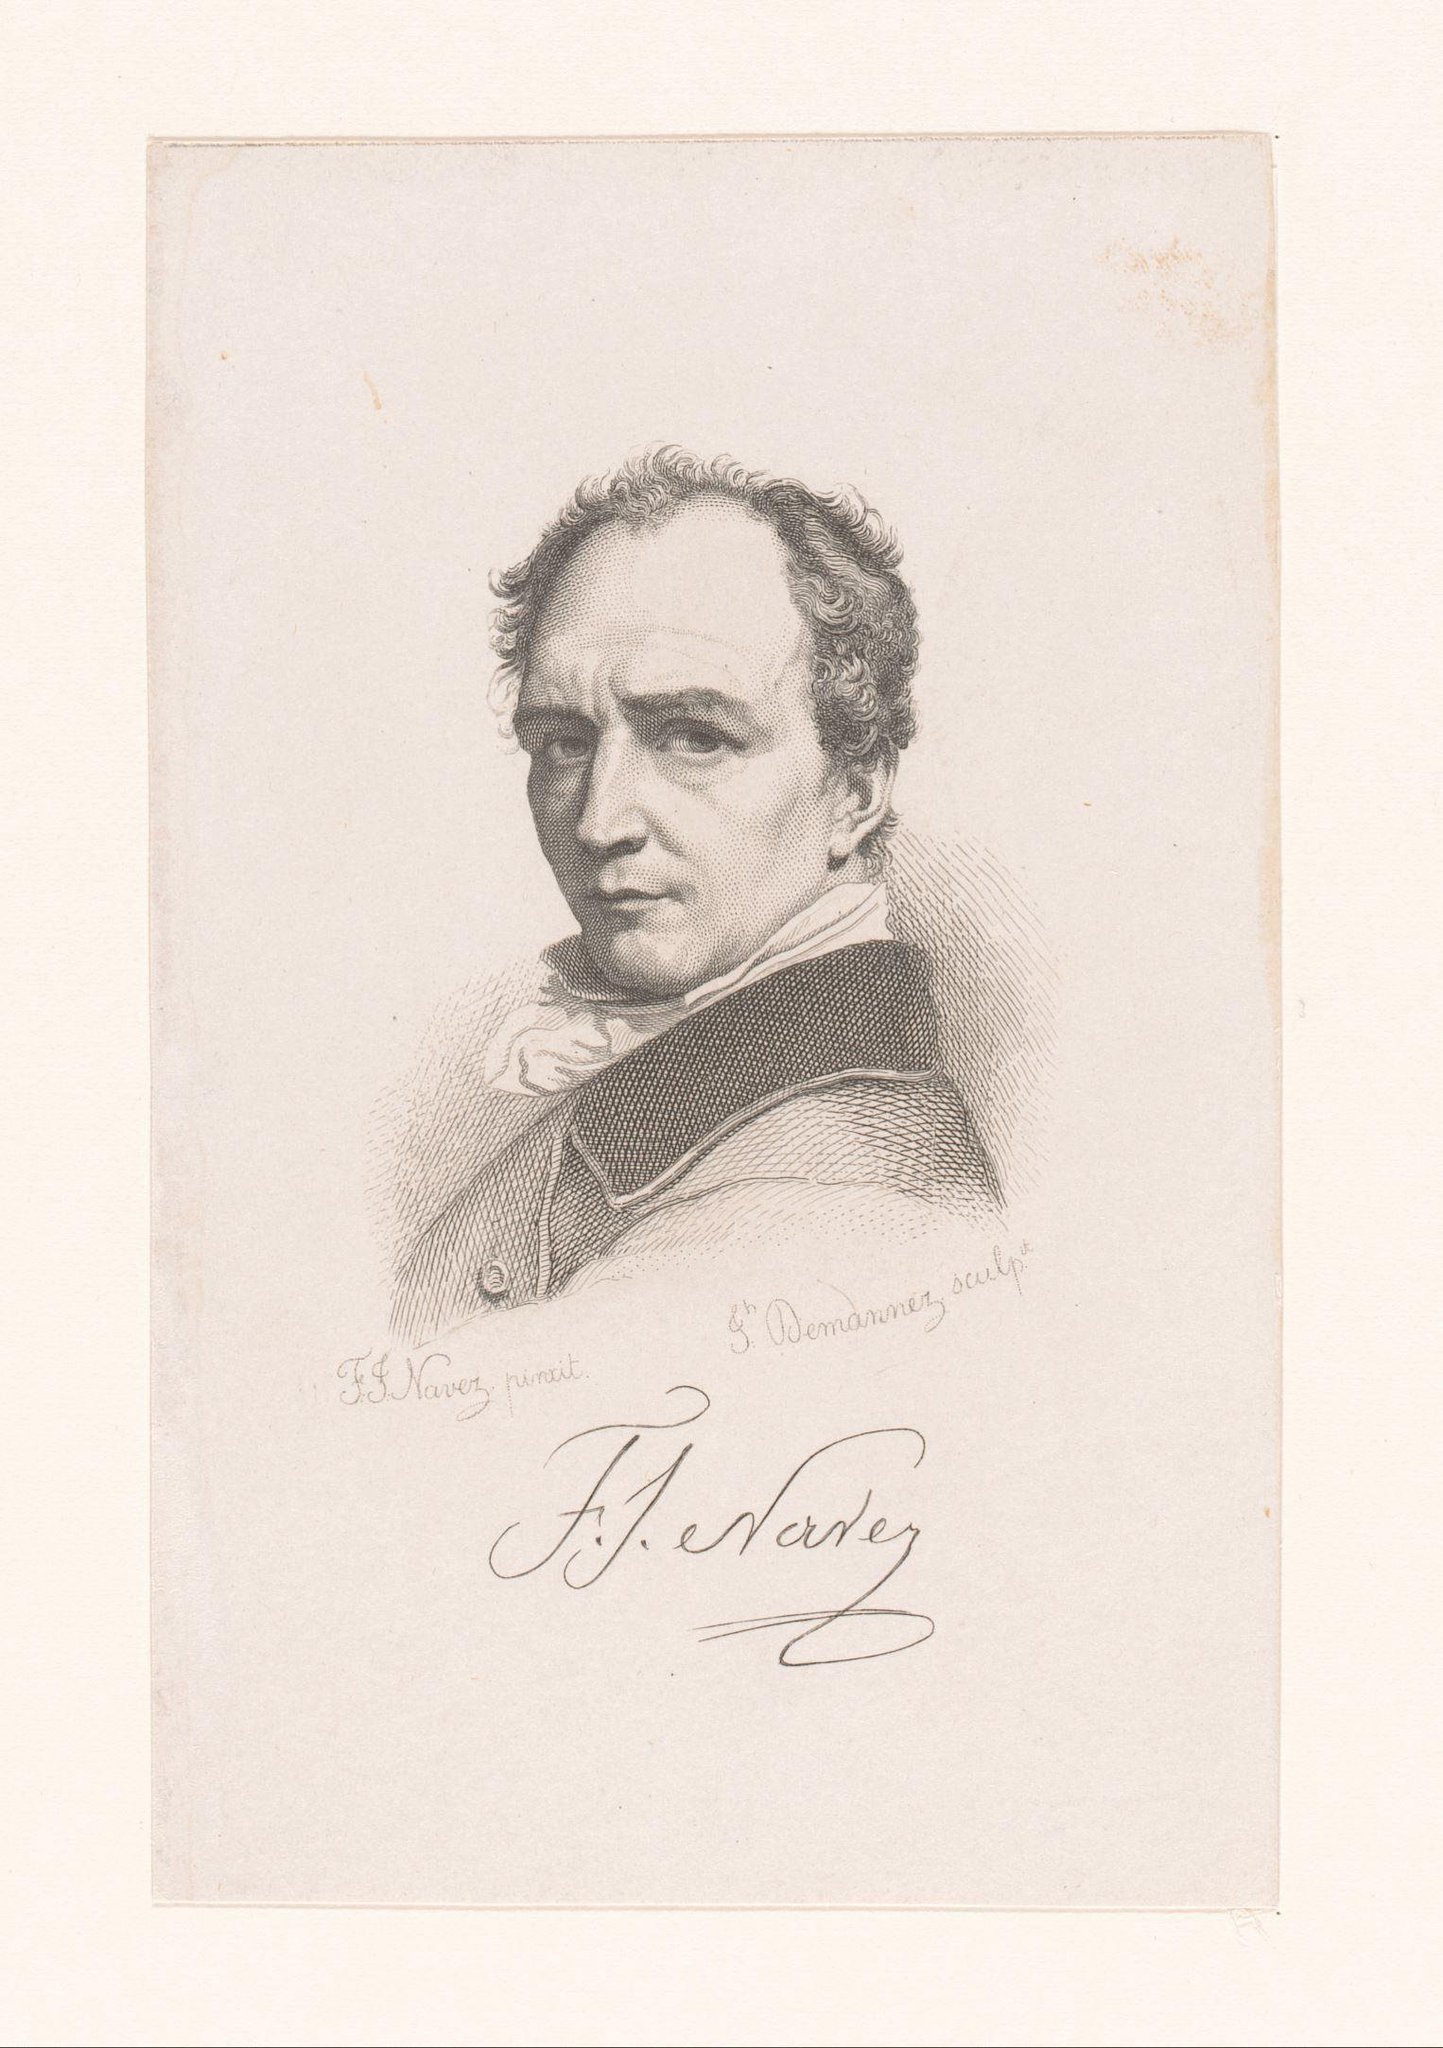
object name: print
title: F.J. Navez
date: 1836-1902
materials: paper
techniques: engraving, etching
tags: brussels, painter, print maker, draughtsman, françois joseph navez, adult man, historical persons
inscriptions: collector's mark: Lugt 2760, collector's mark: Lugt 2228